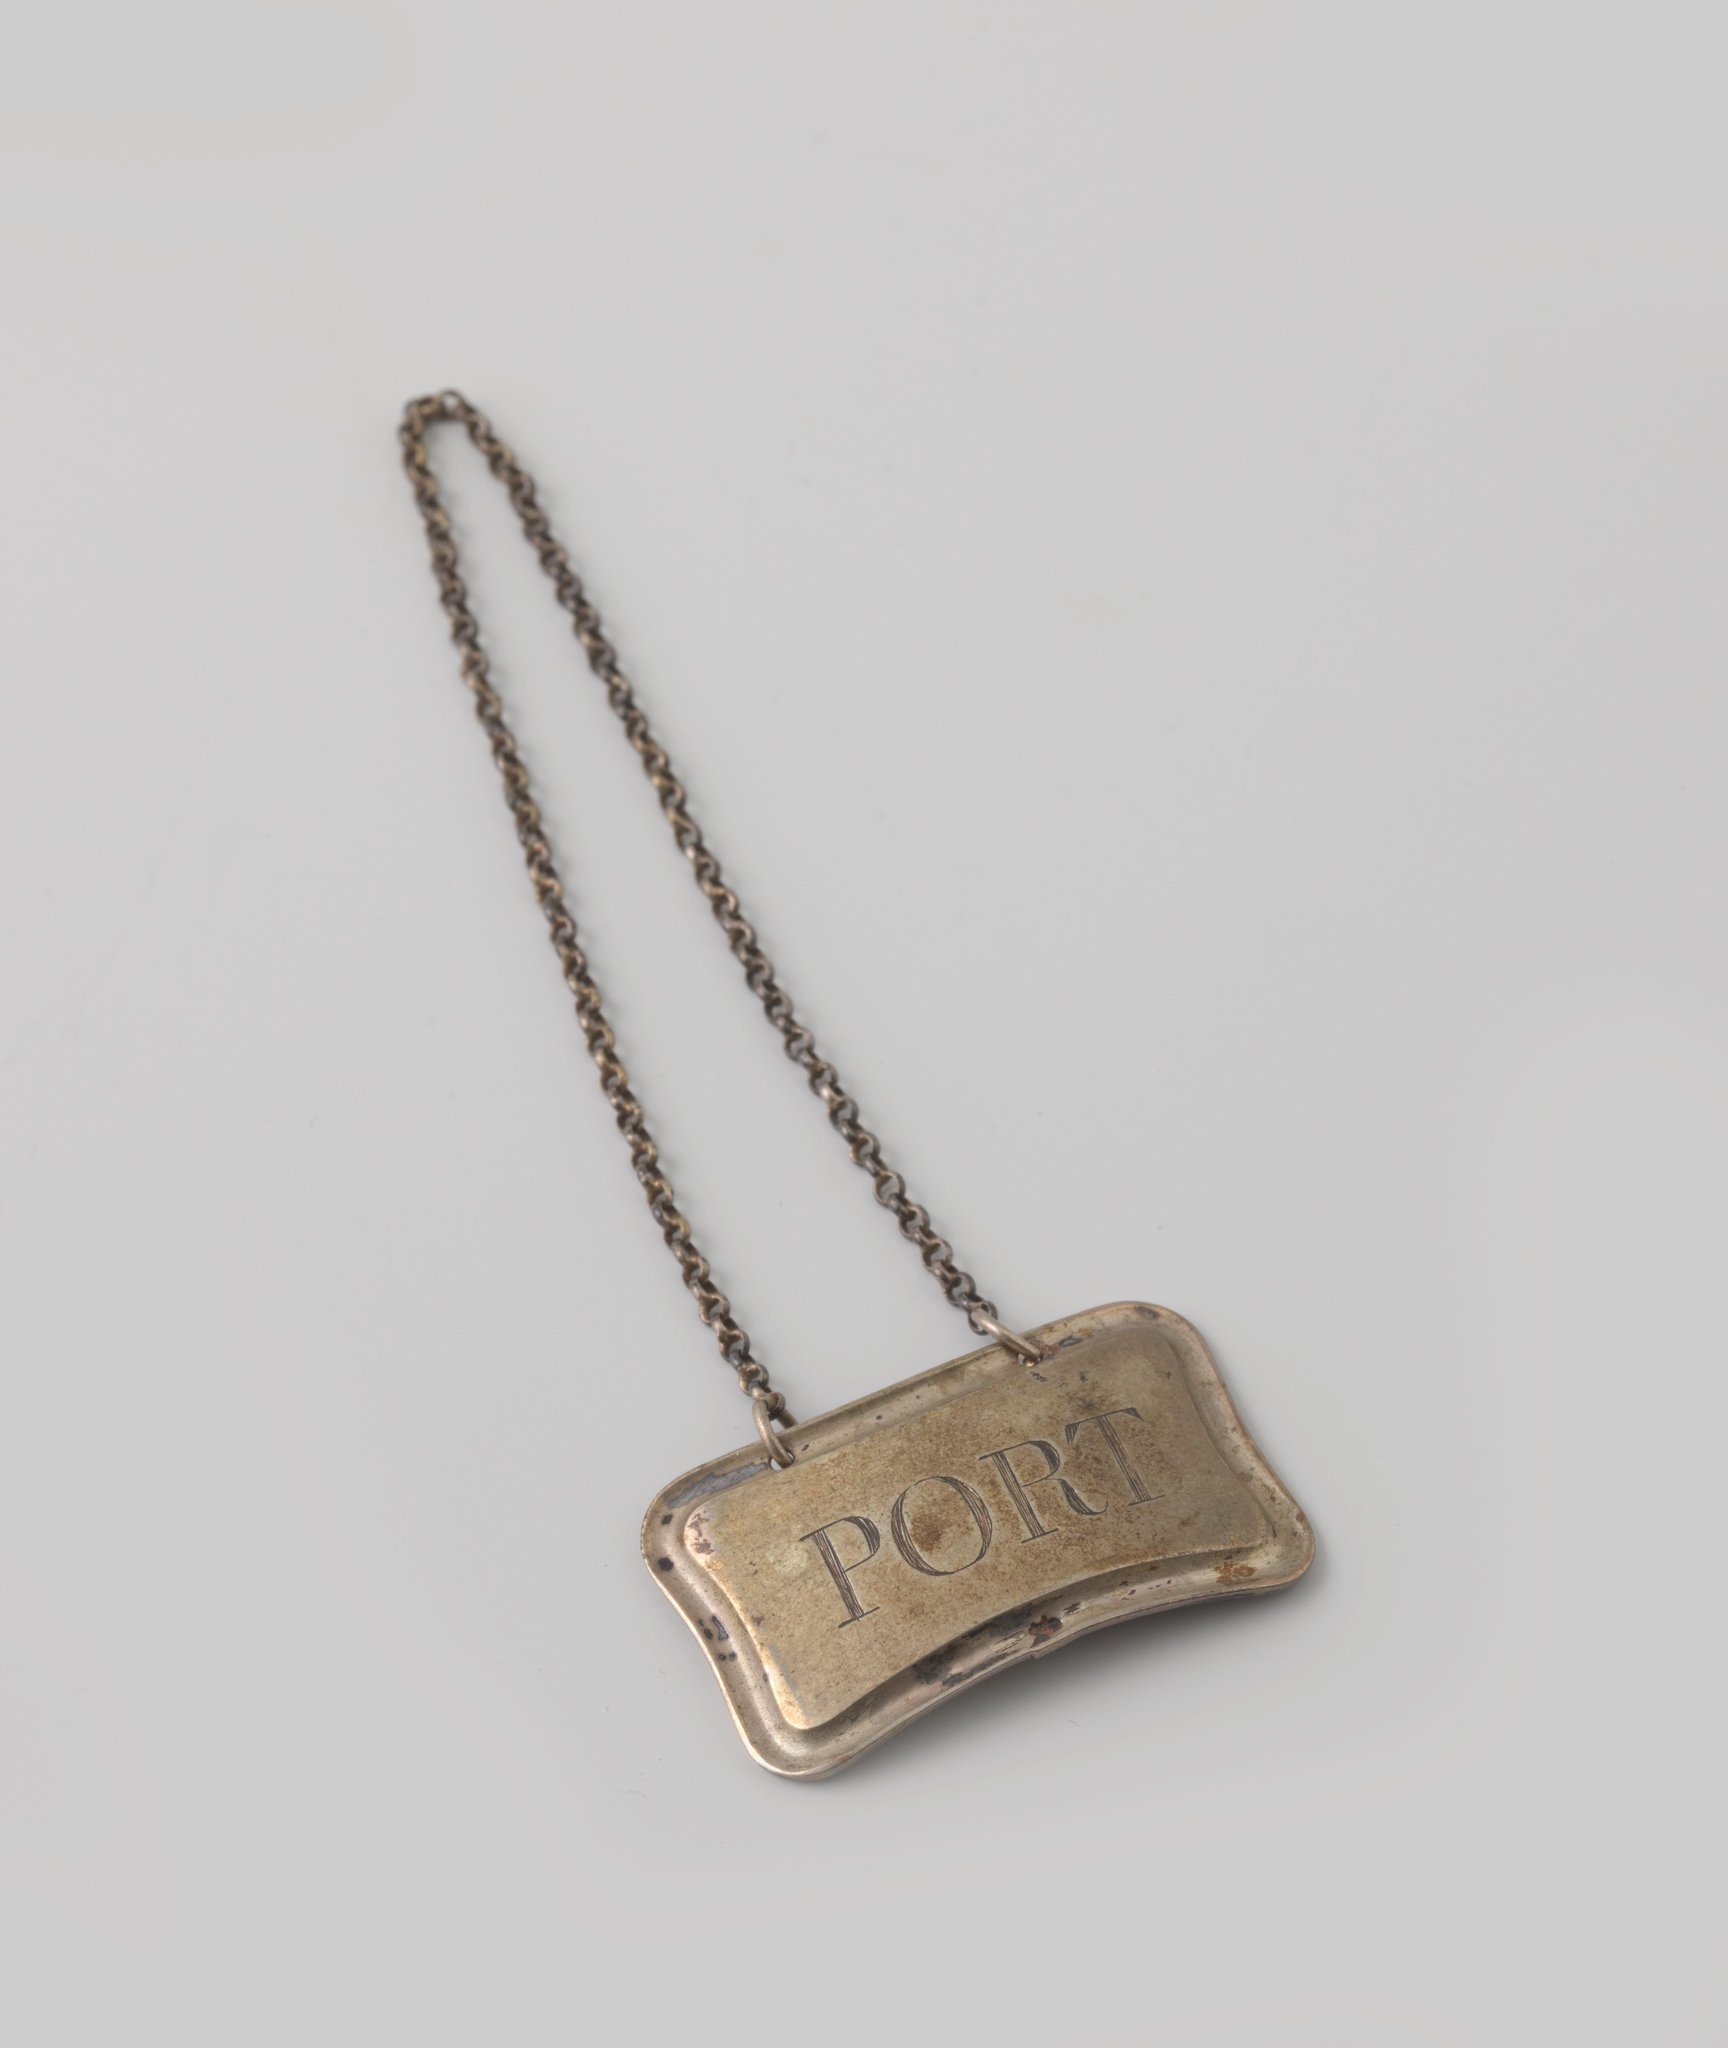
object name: label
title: Flessenlabel met Port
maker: Anonymous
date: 1800-1900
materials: silver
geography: great britain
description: Wijnetiket van zilver, aan een ketting. Opschrift: PORT.